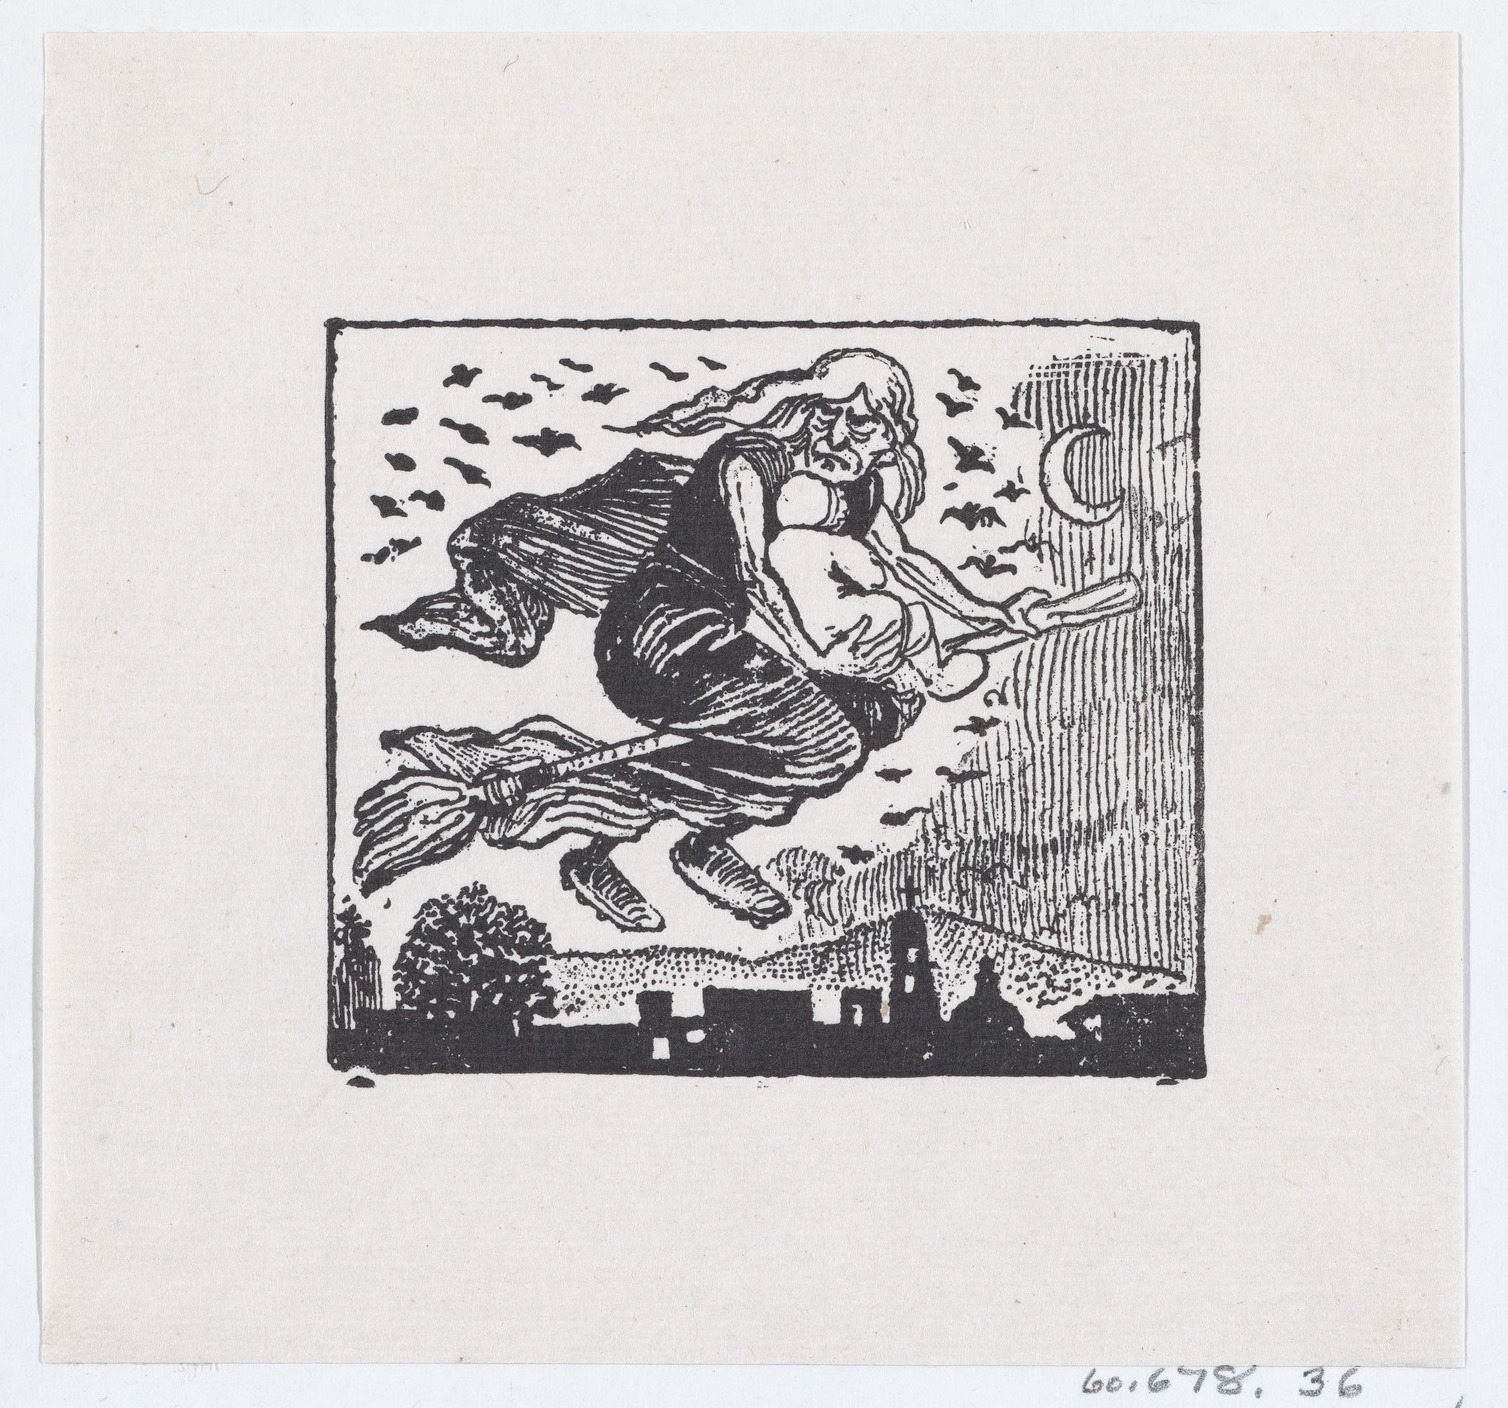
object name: print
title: A witch carrying a child on her broom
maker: josé guadalupe posada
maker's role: artist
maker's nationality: mexican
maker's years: 1852-1913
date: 1880-1910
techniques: lithography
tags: children,women,witches